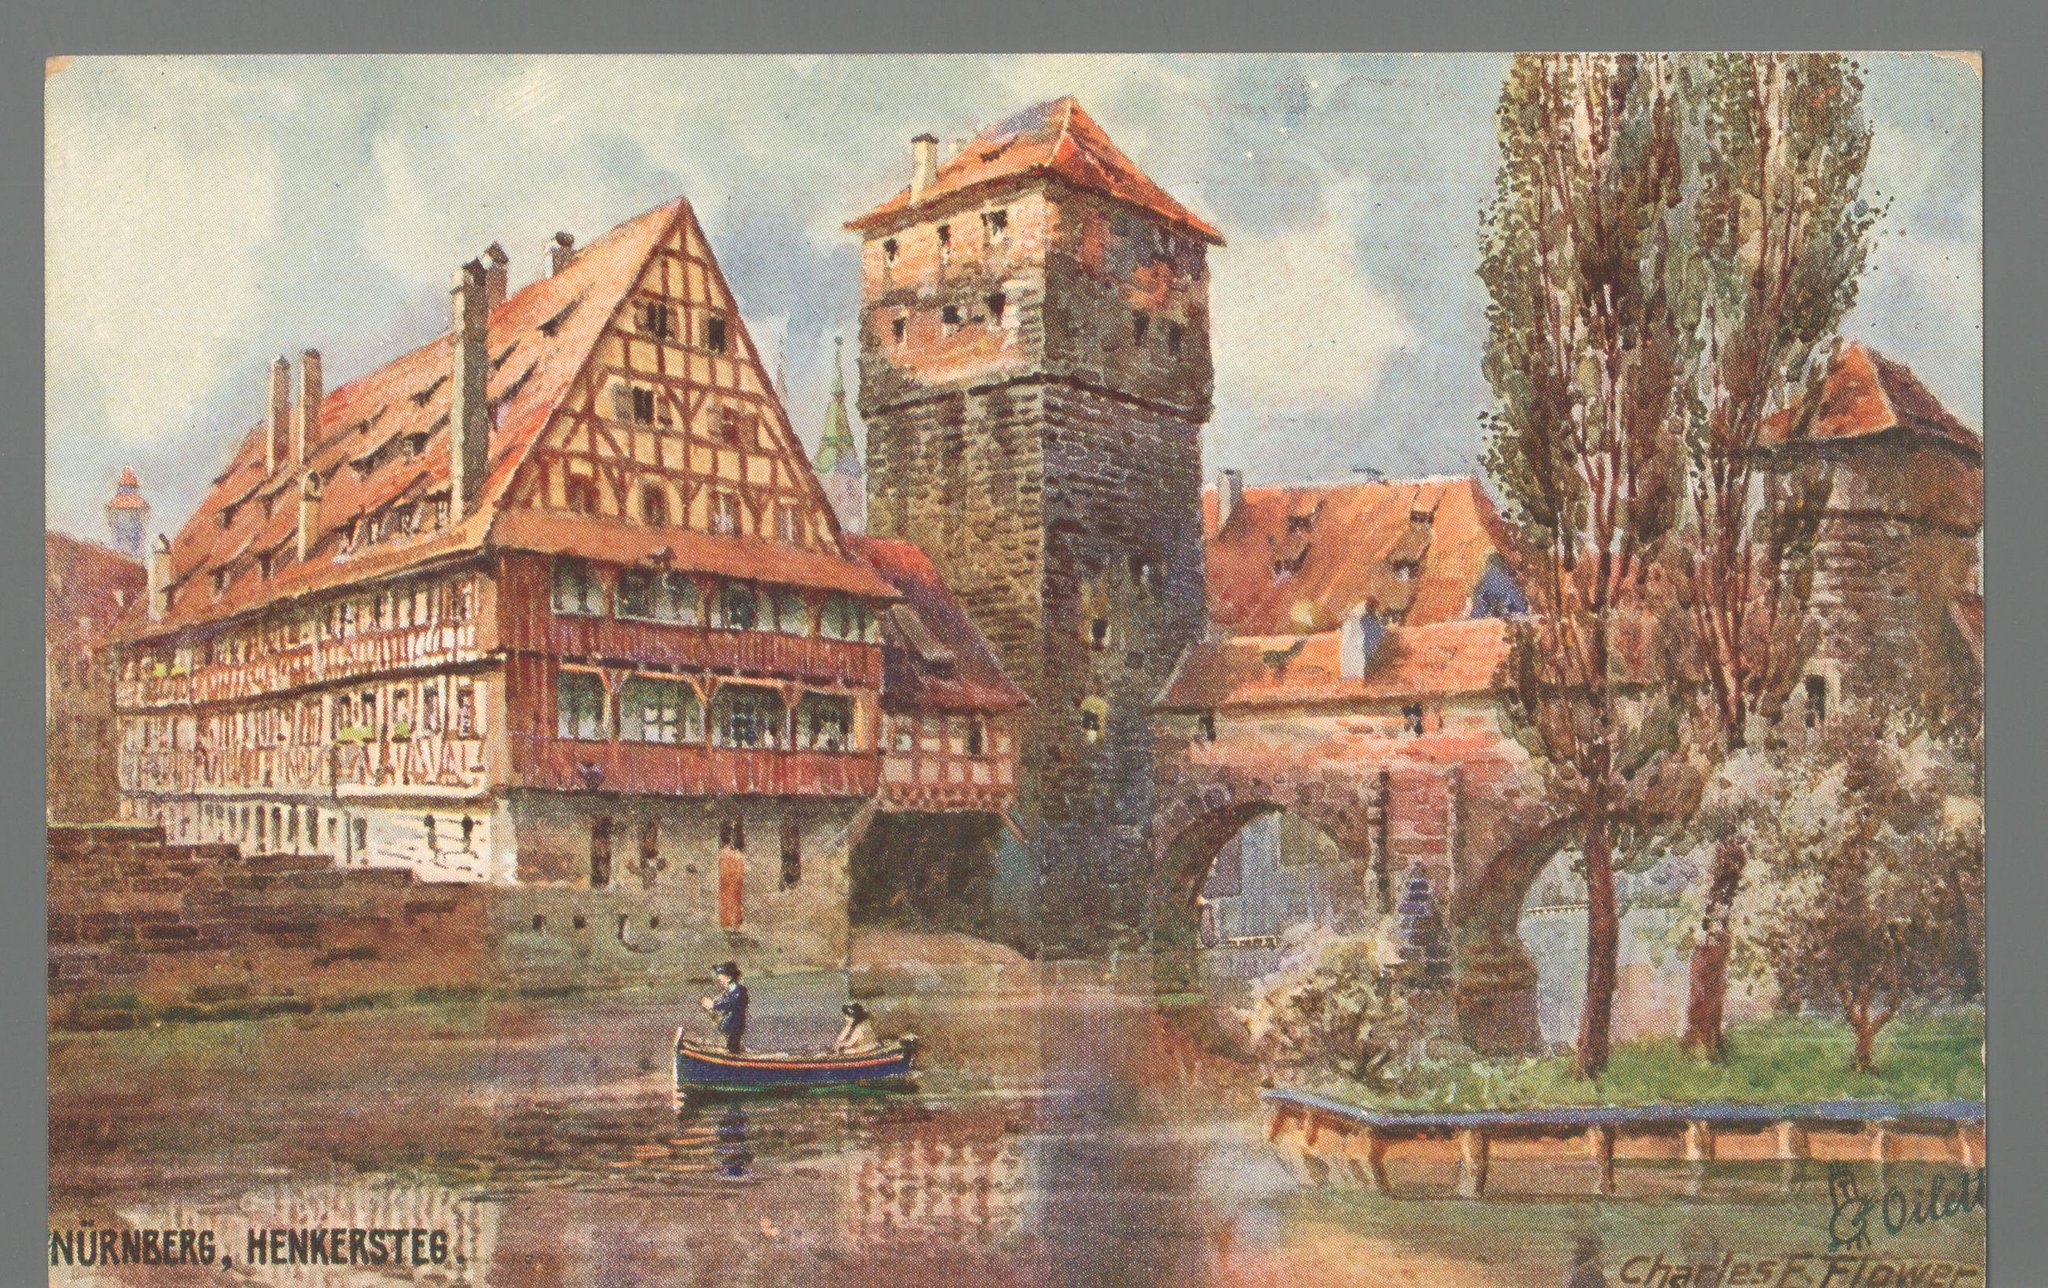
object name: reproduction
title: Nürnberg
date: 1908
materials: cardboard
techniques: writing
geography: london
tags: towers ~ fortified city, canals, waters (in city), bridge in city across river, canal, etc.